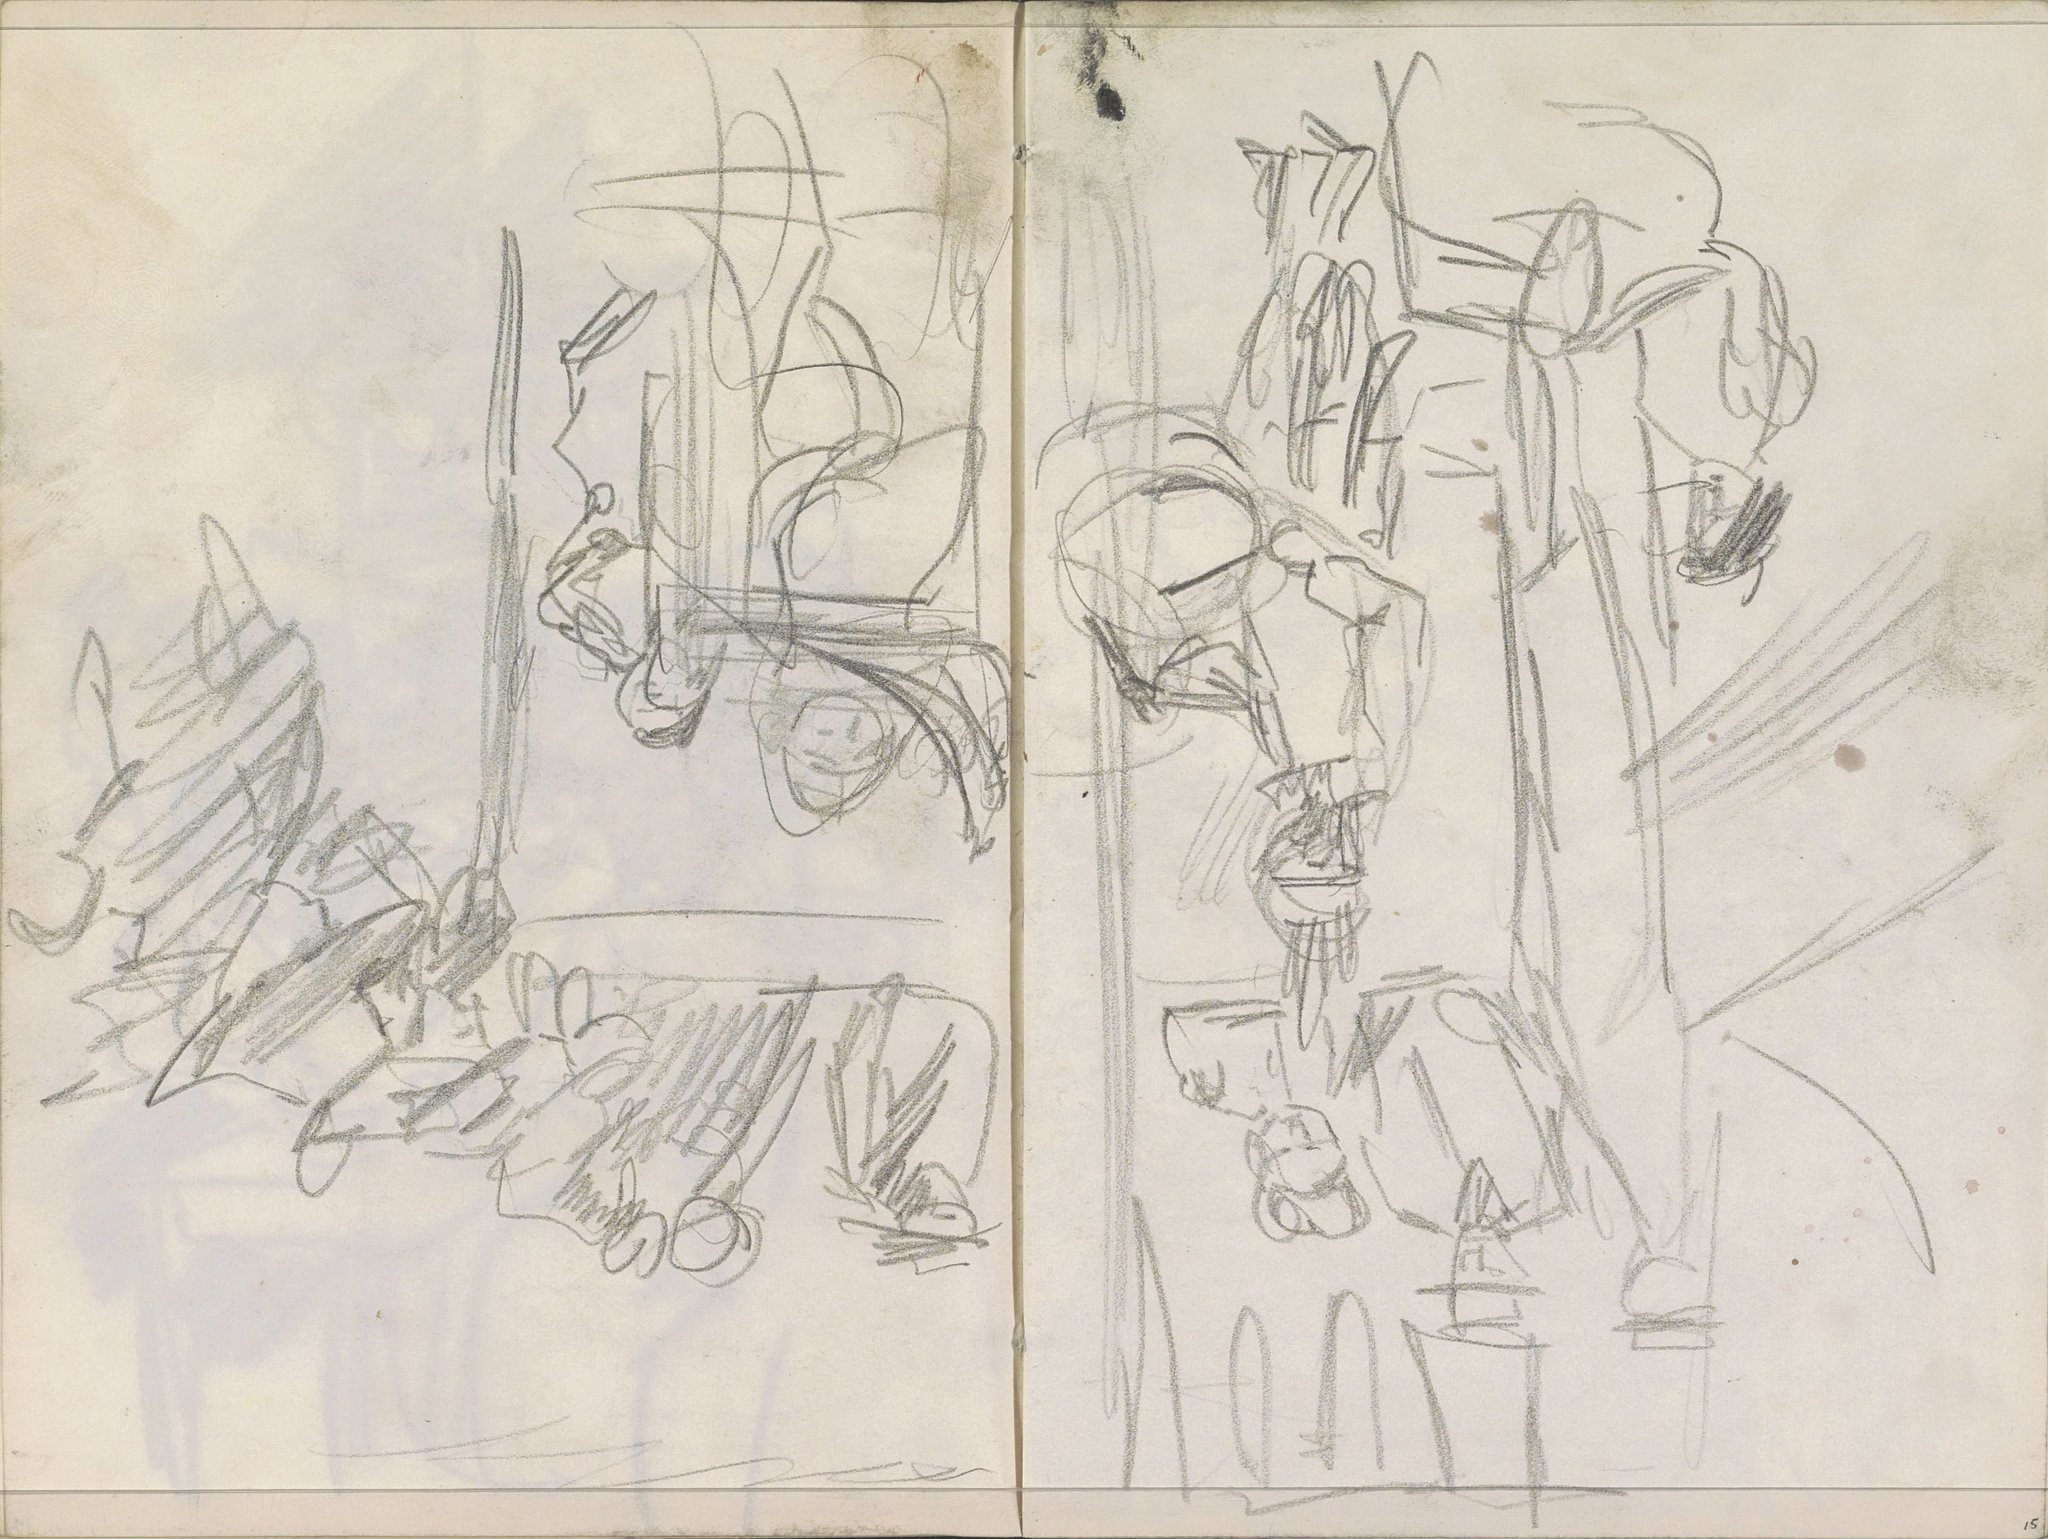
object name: sketchbook leaf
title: Toehoorders rond een groep muzikanten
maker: isaac israels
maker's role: draughtsman, painter, print maker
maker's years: 1865-1934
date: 1875-1934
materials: paper, pencil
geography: paris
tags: small group of musicians, chamber orchestra, jazz band, drum (musical instrument), the audience ~ art performance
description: In het midden muzikanten, onder andere een trommelaar. Figuren kijken toe vanaf een balkon of galerij. Blad 14 verso en blad 15 recto uit schetsboek L met 42 bladen.